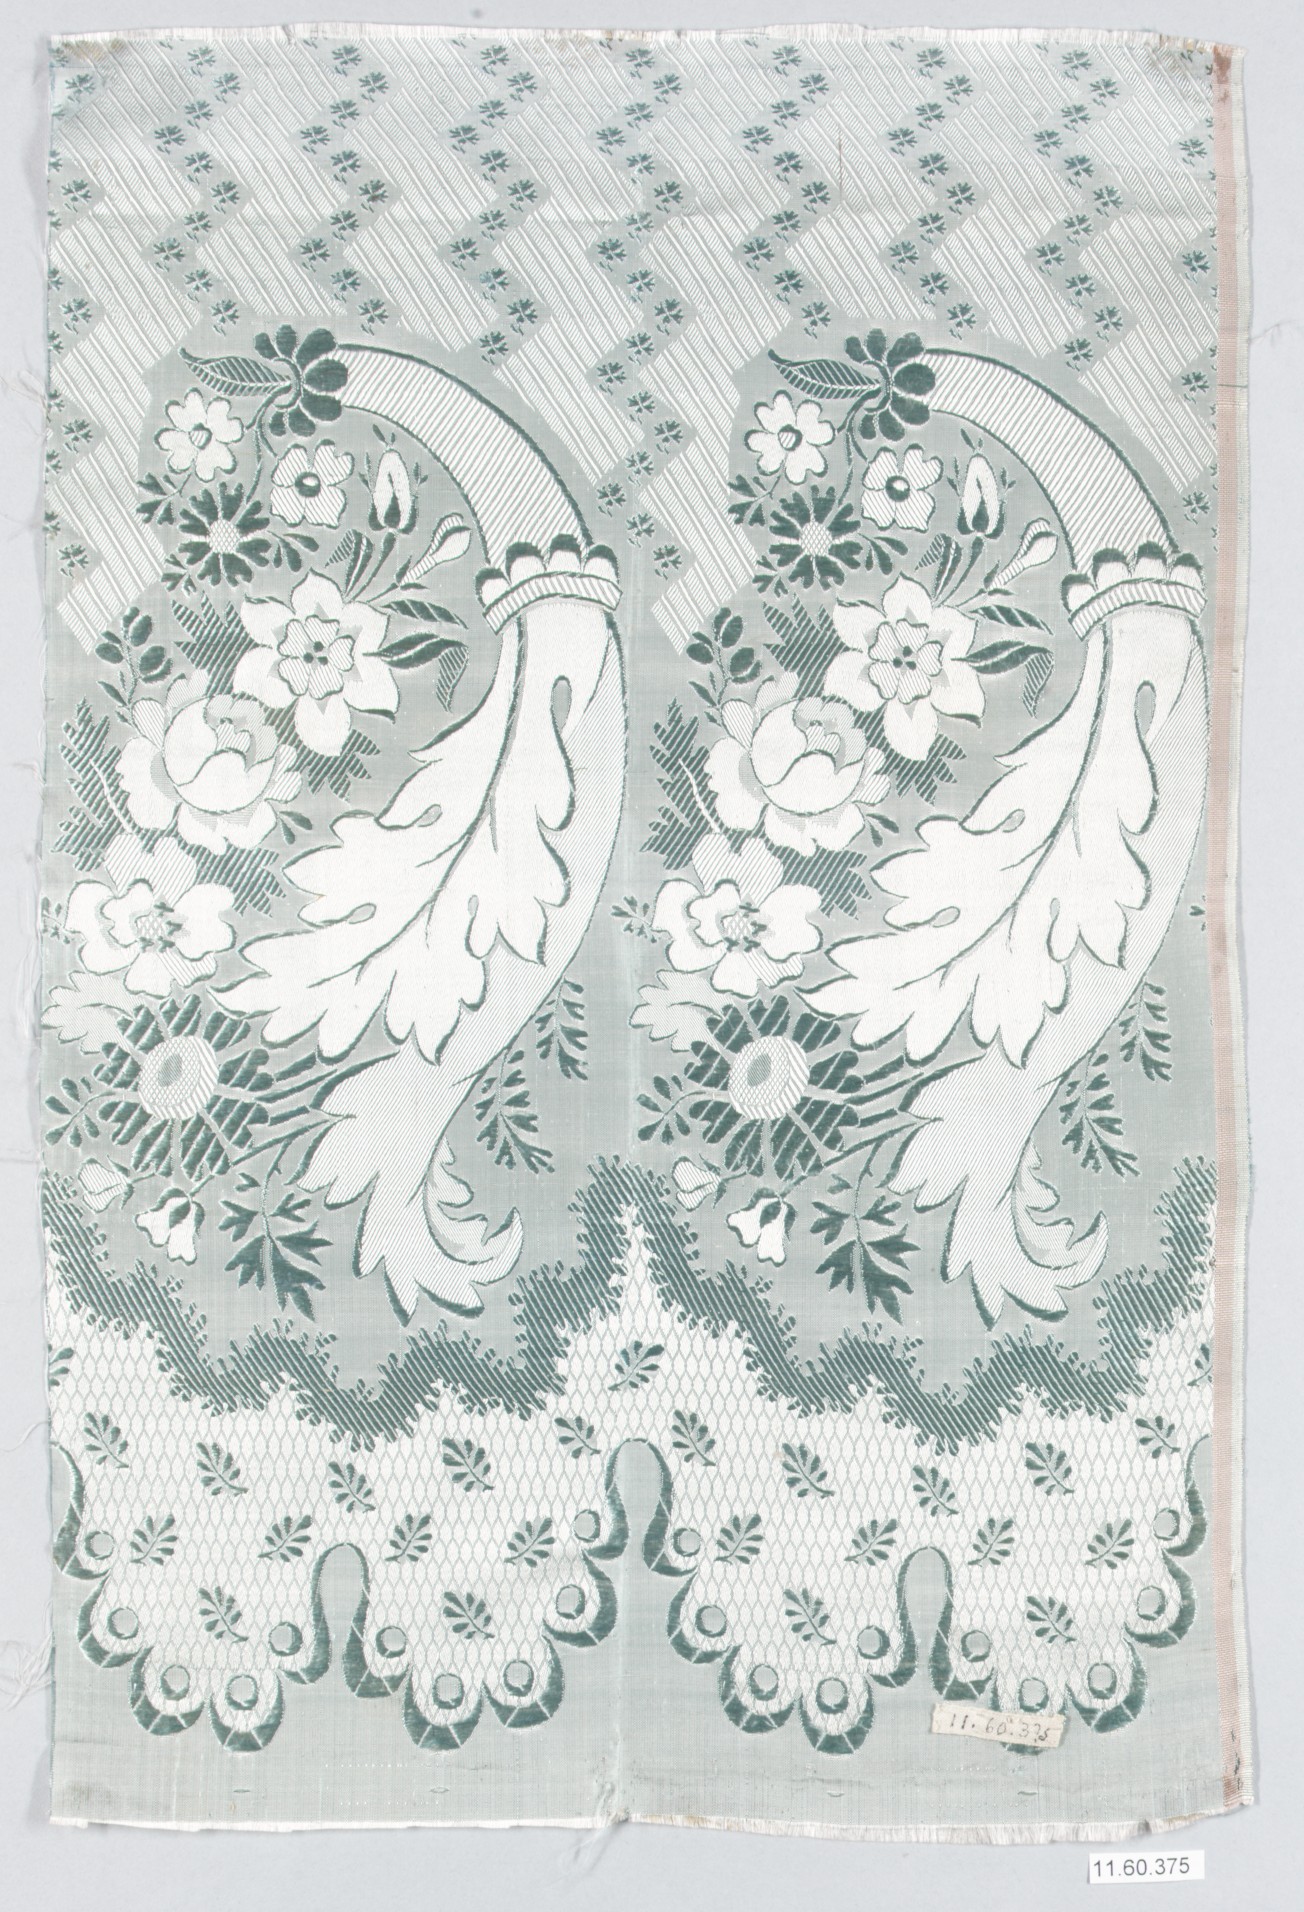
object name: fragment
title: Fragments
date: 1801-1900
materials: silk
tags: flowers,leaves